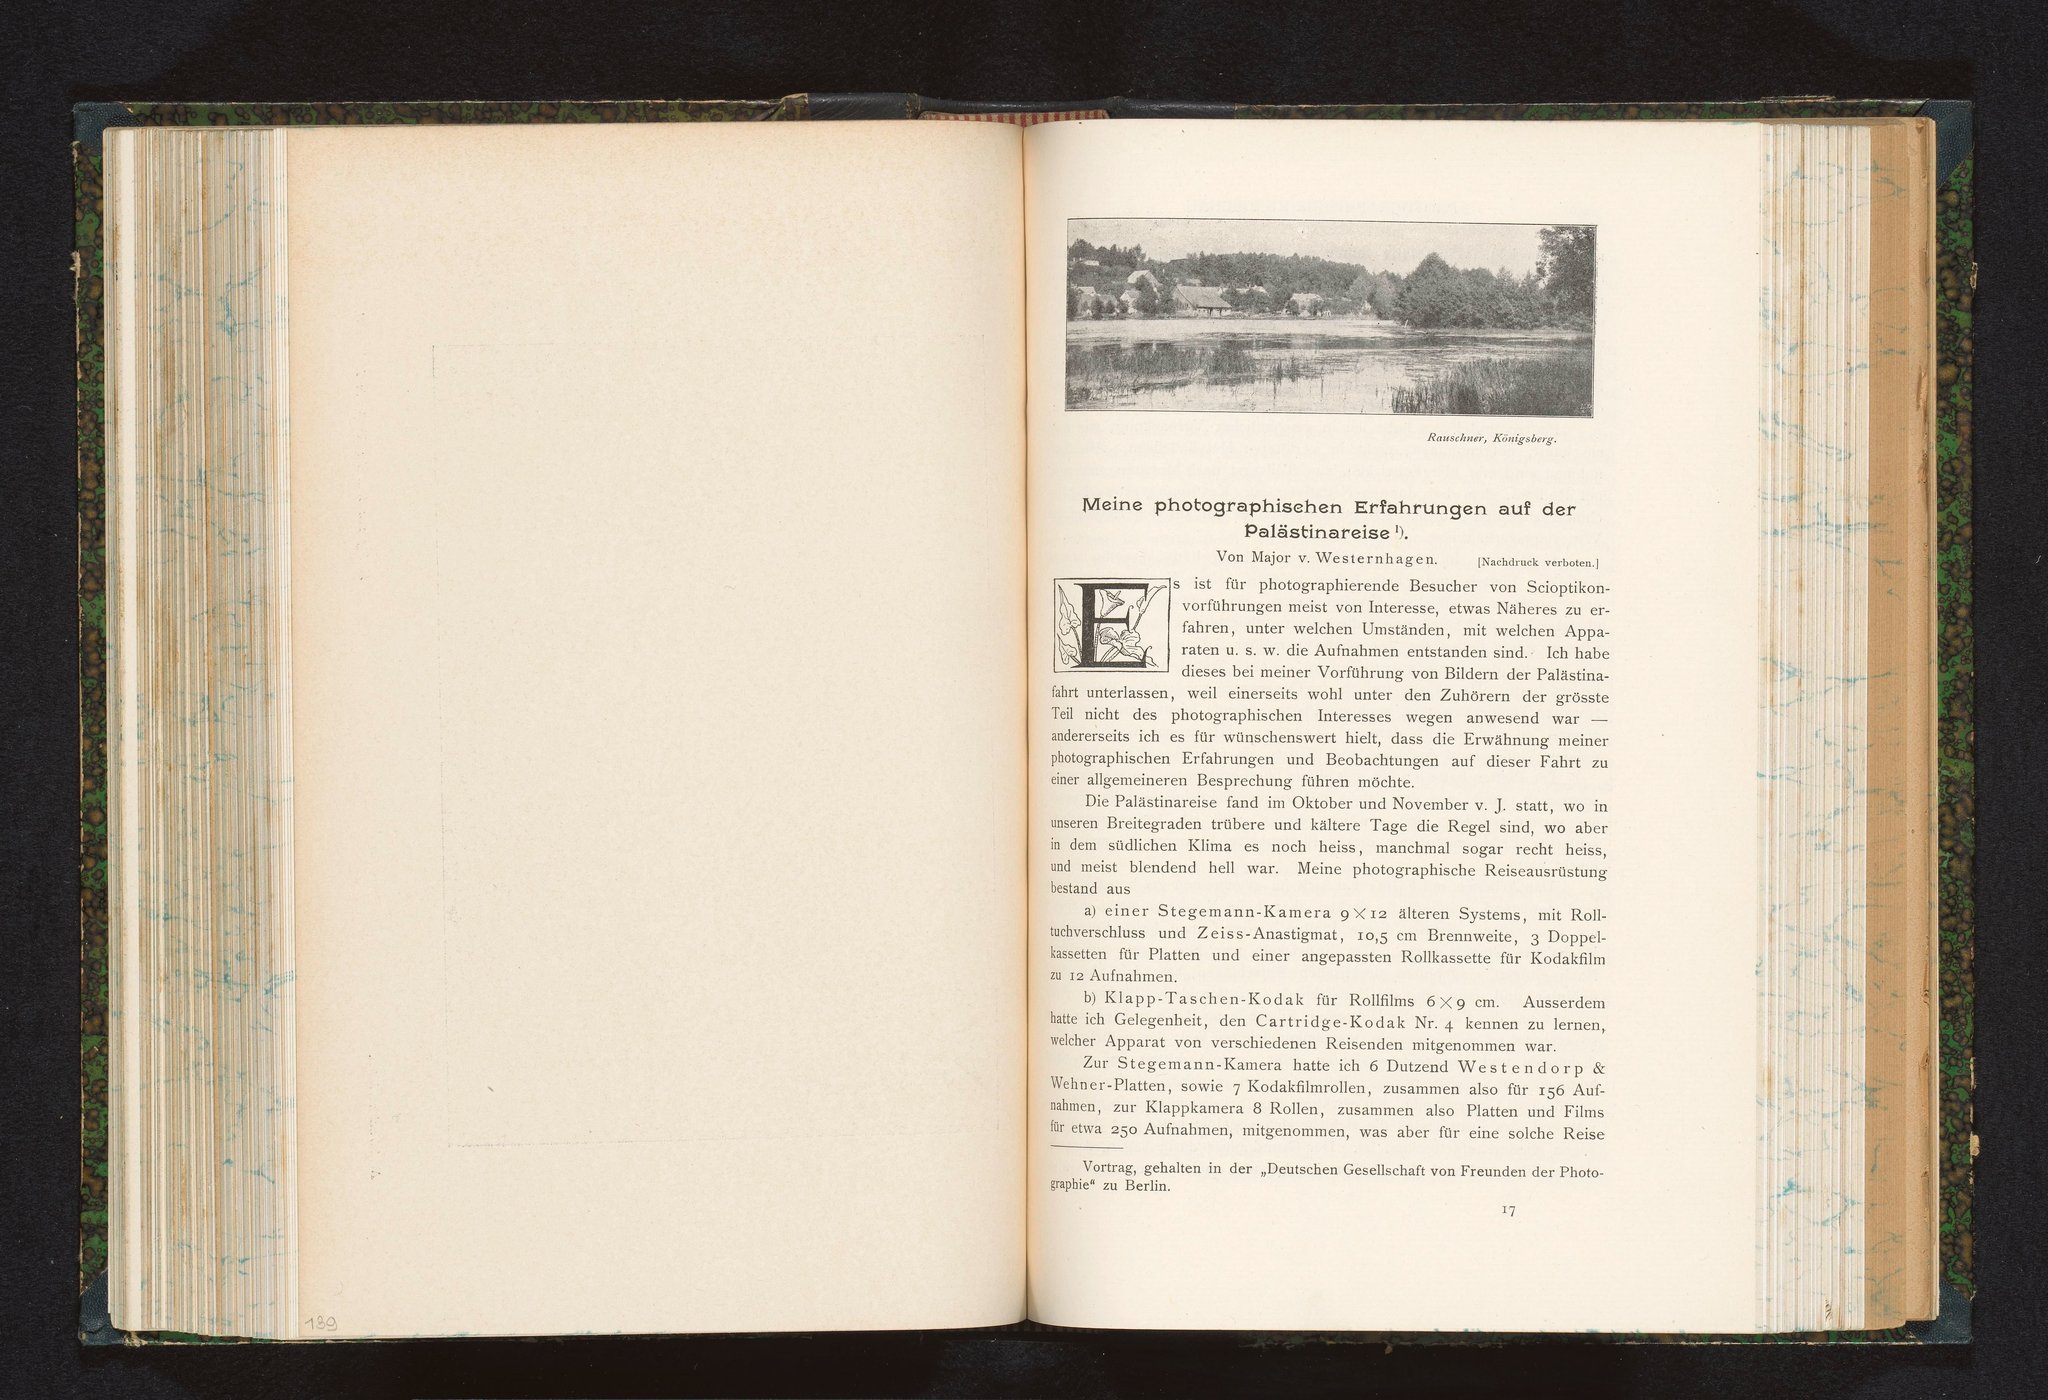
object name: page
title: Gezicht op een rivier, met op de achtergrond een dorp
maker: rauschner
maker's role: fotograaf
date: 1894-1899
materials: paper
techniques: autotype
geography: berlin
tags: river, village